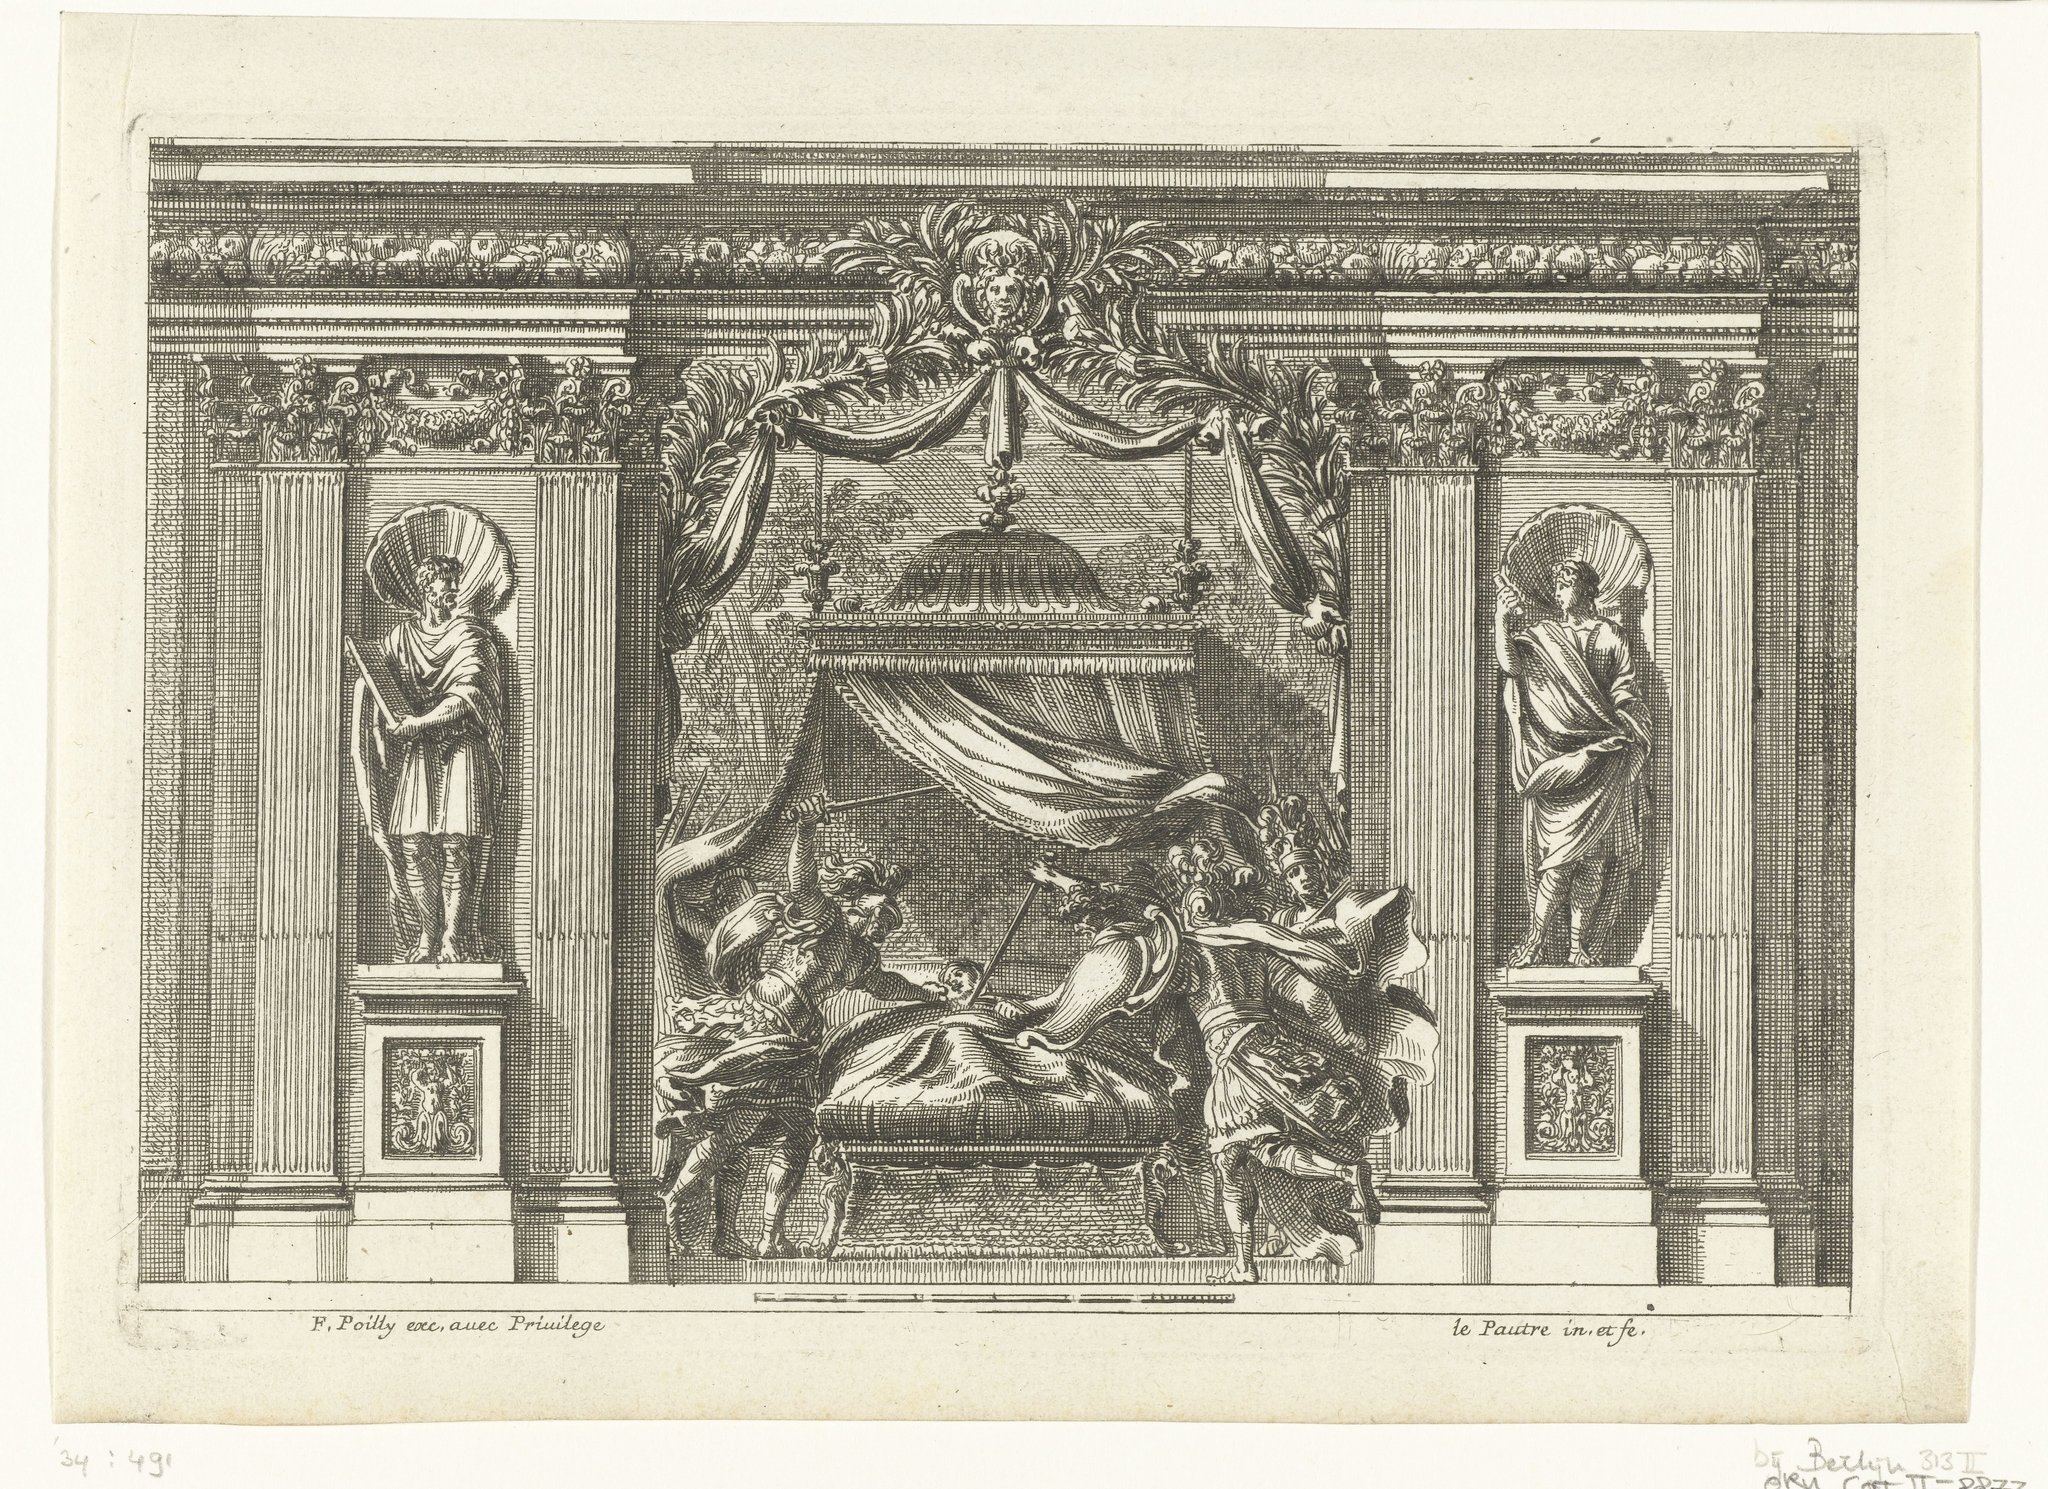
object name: print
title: Alkoof met soldaten die man doden in bed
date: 1665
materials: paper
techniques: etching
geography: france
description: De muur is gedecoreerd met gekoppelde Korintische pilasters, daartussen staat een beeld van een man op een voetstuk. Uit serie van 6 bladen.